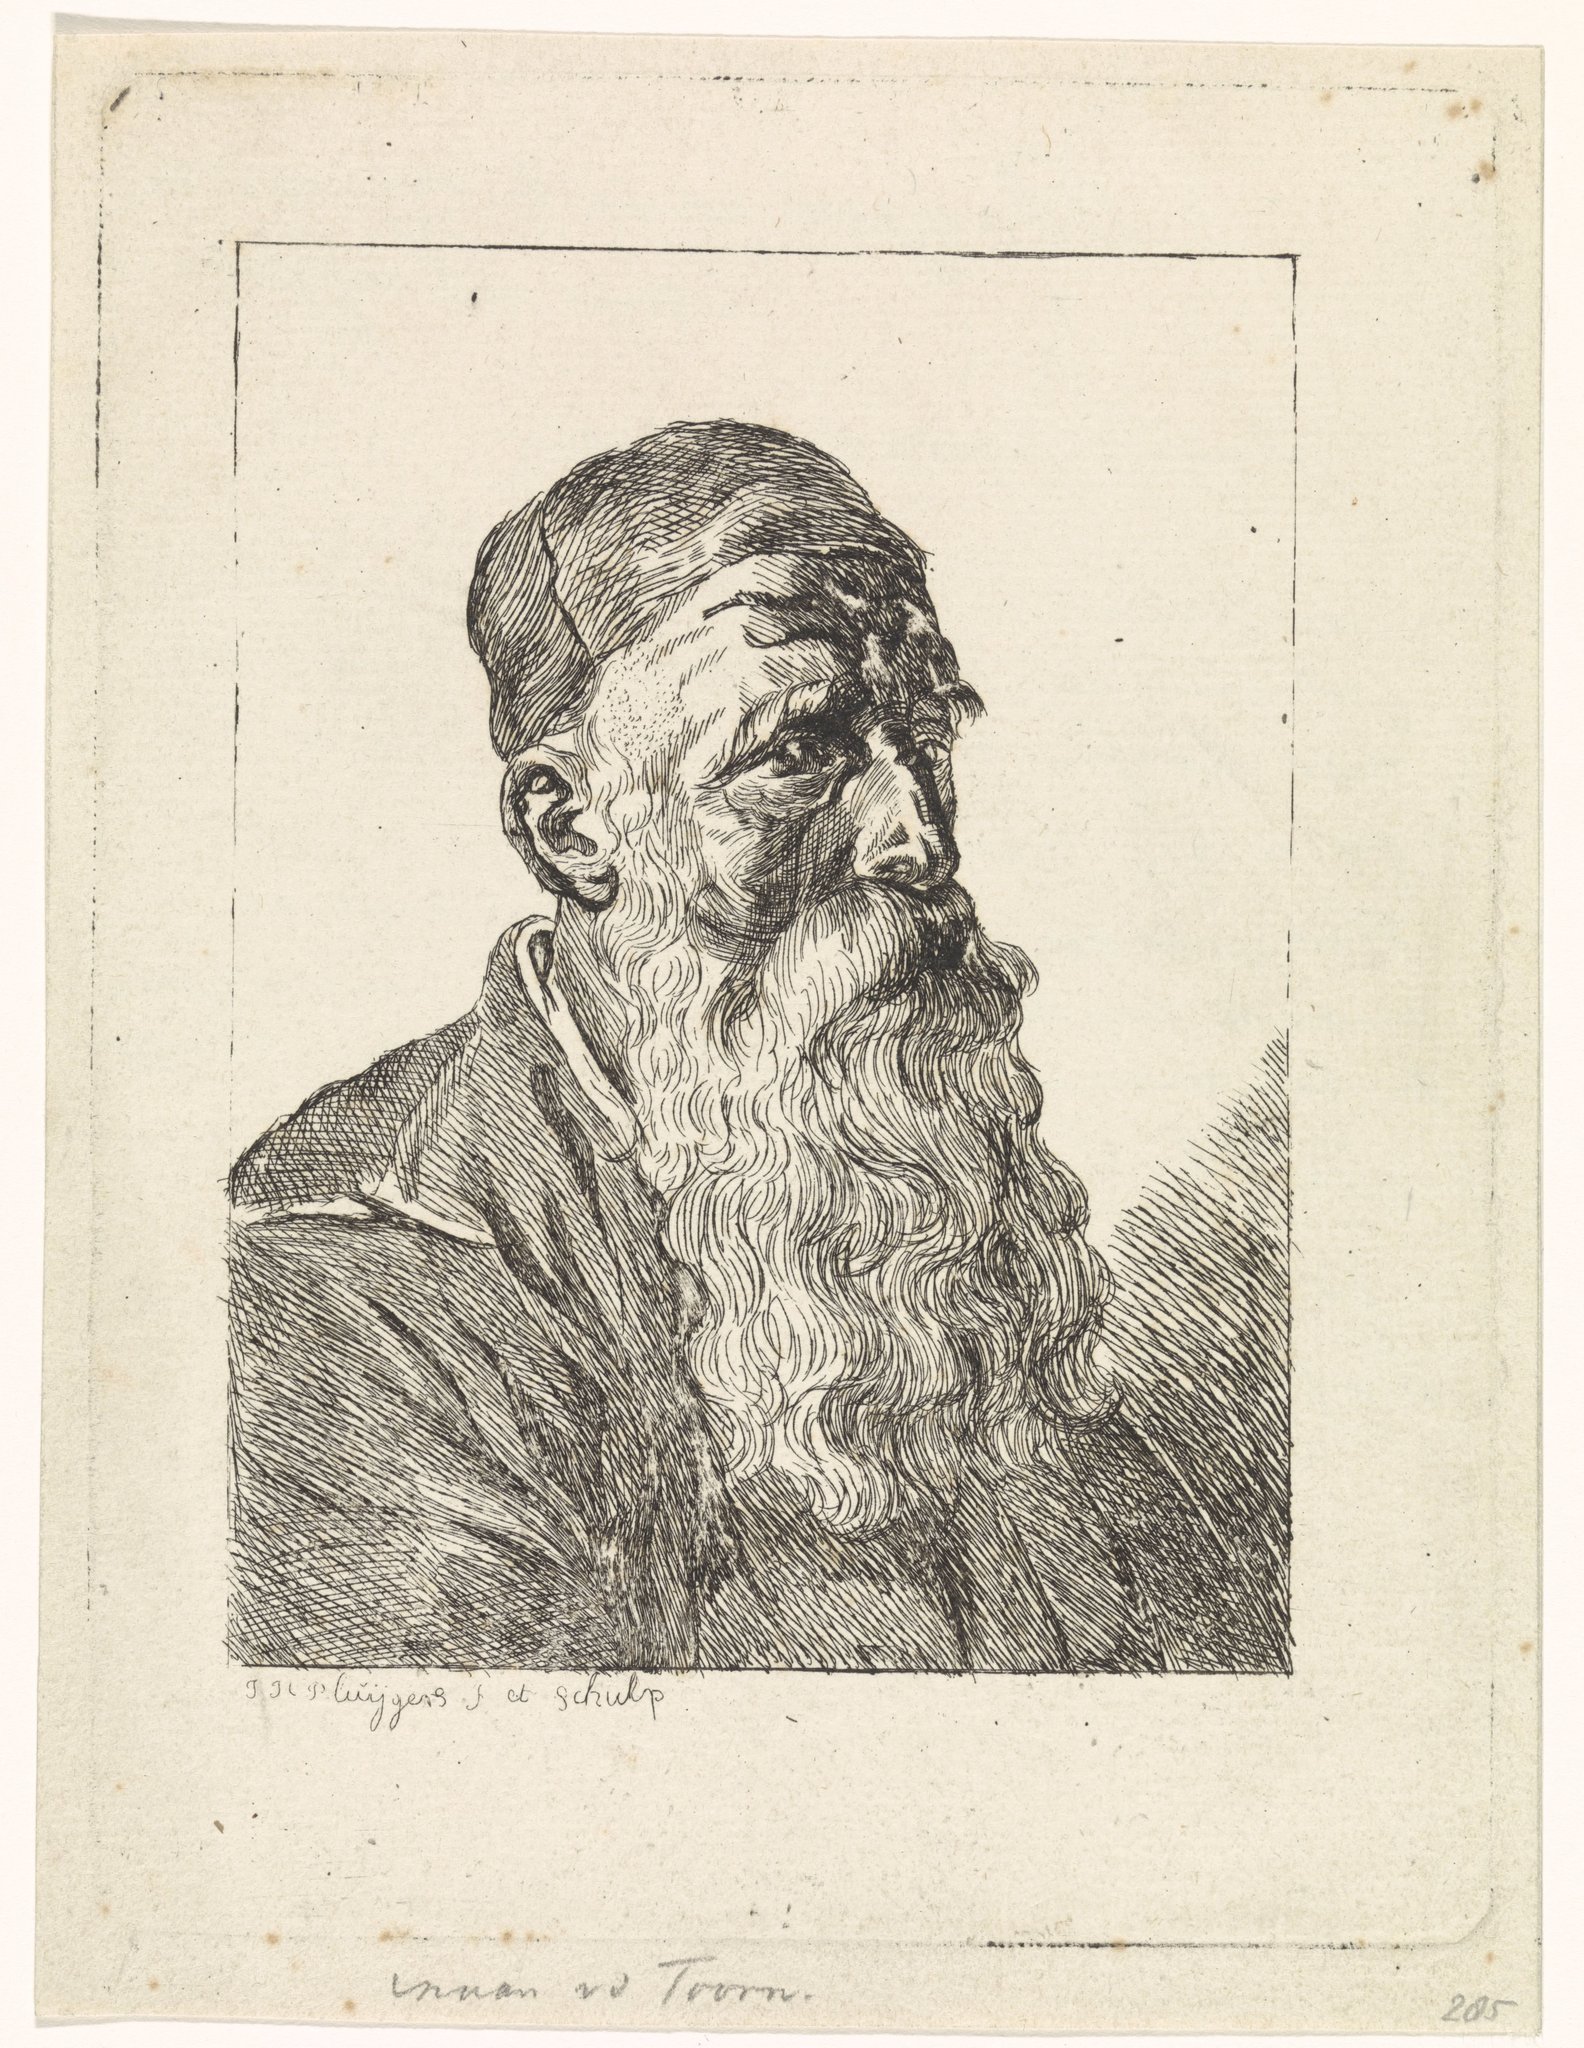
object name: print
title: Portret van een onbekende man met baard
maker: j.h. pluygers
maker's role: print maker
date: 1800-1899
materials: paper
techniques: etching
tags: anonymous historical person portrayed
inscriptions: collector's mark: Lugt 2227